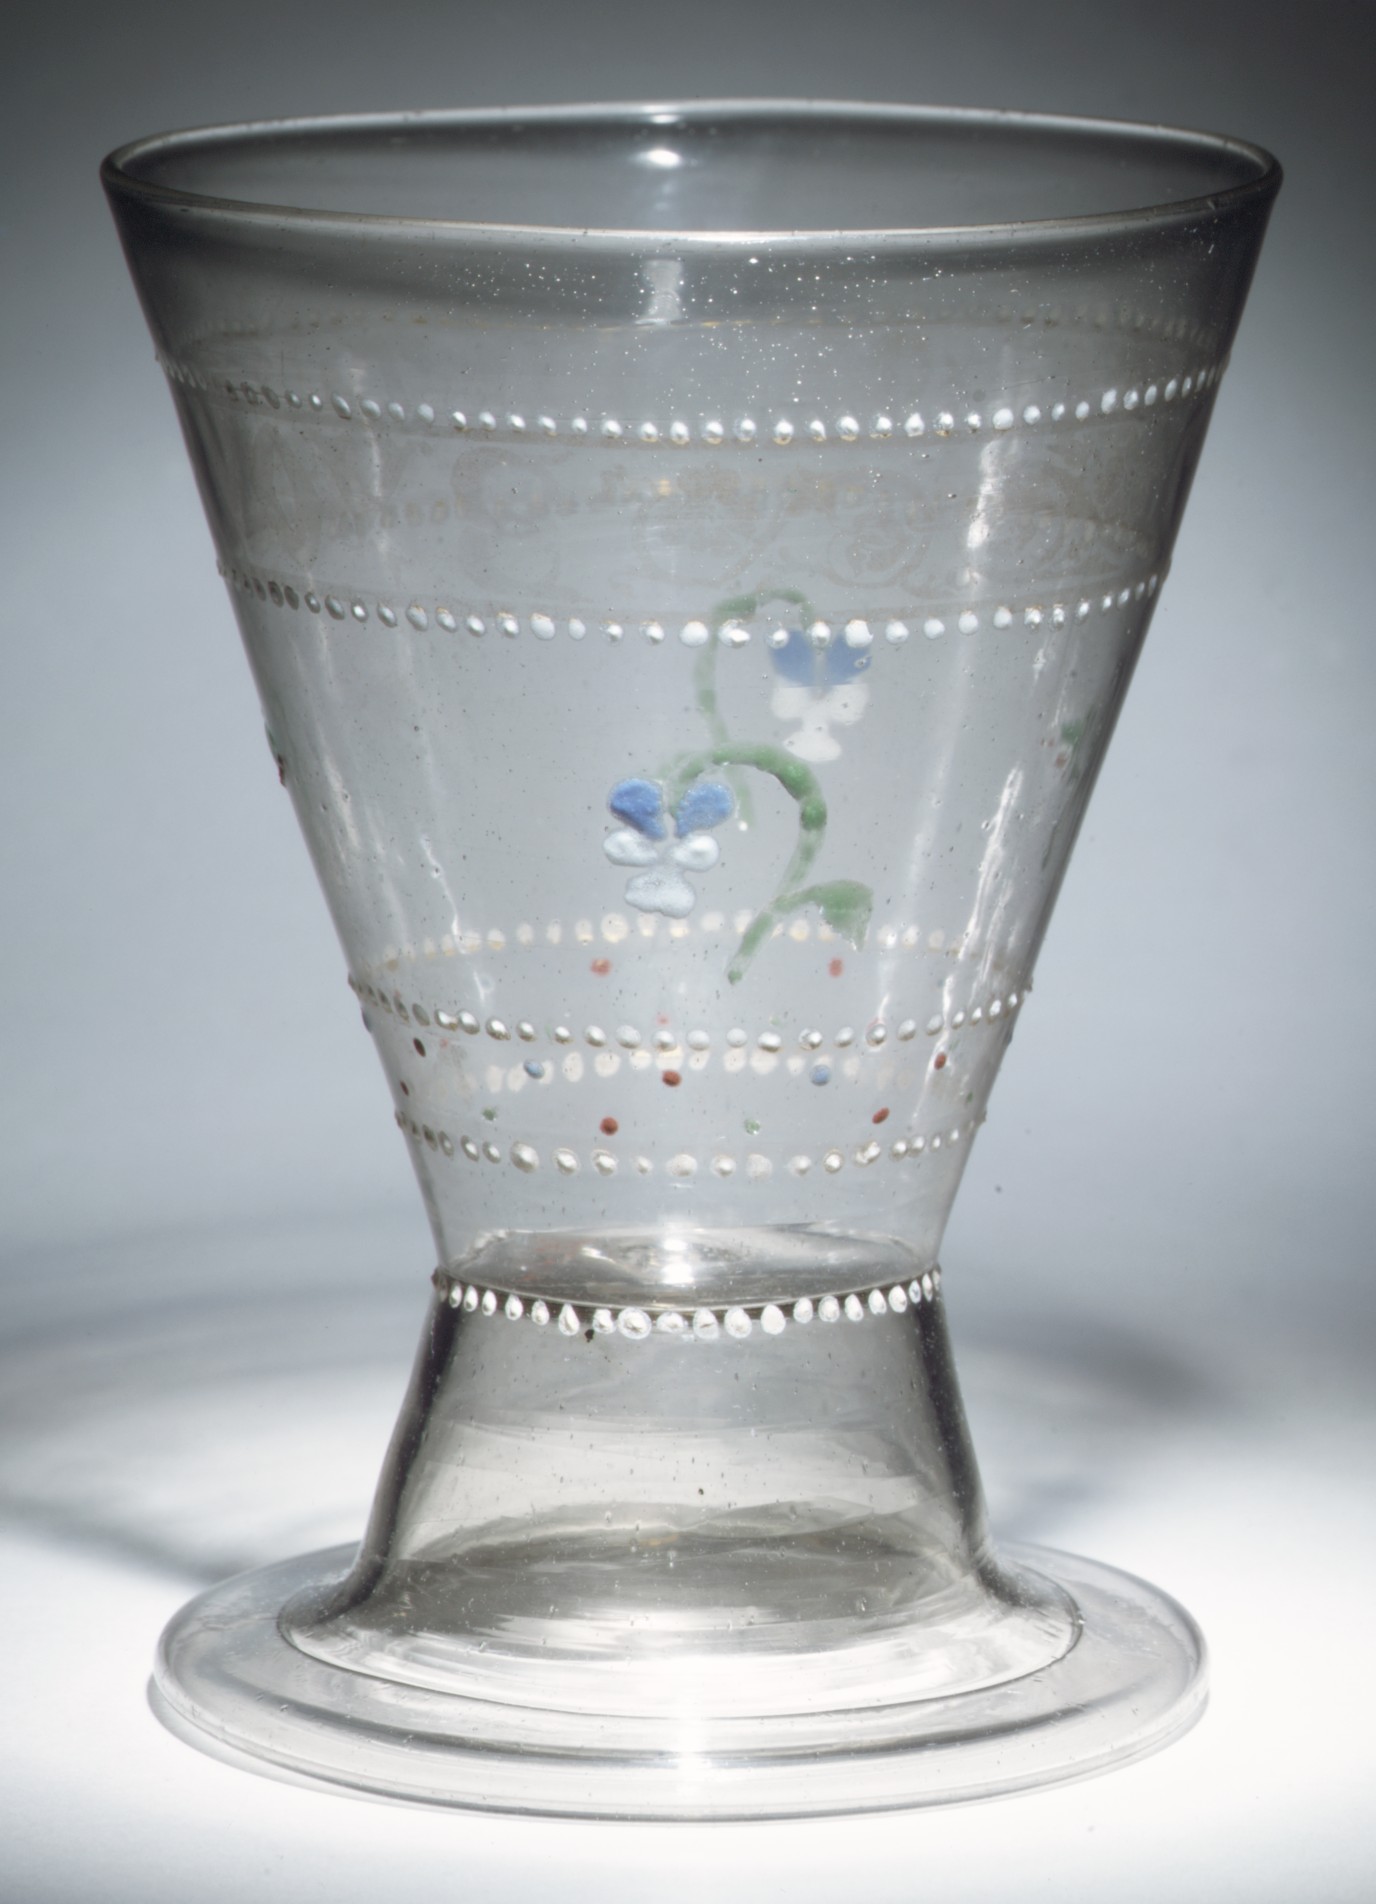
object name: beaker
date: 1501-1550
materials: glass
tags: flowers